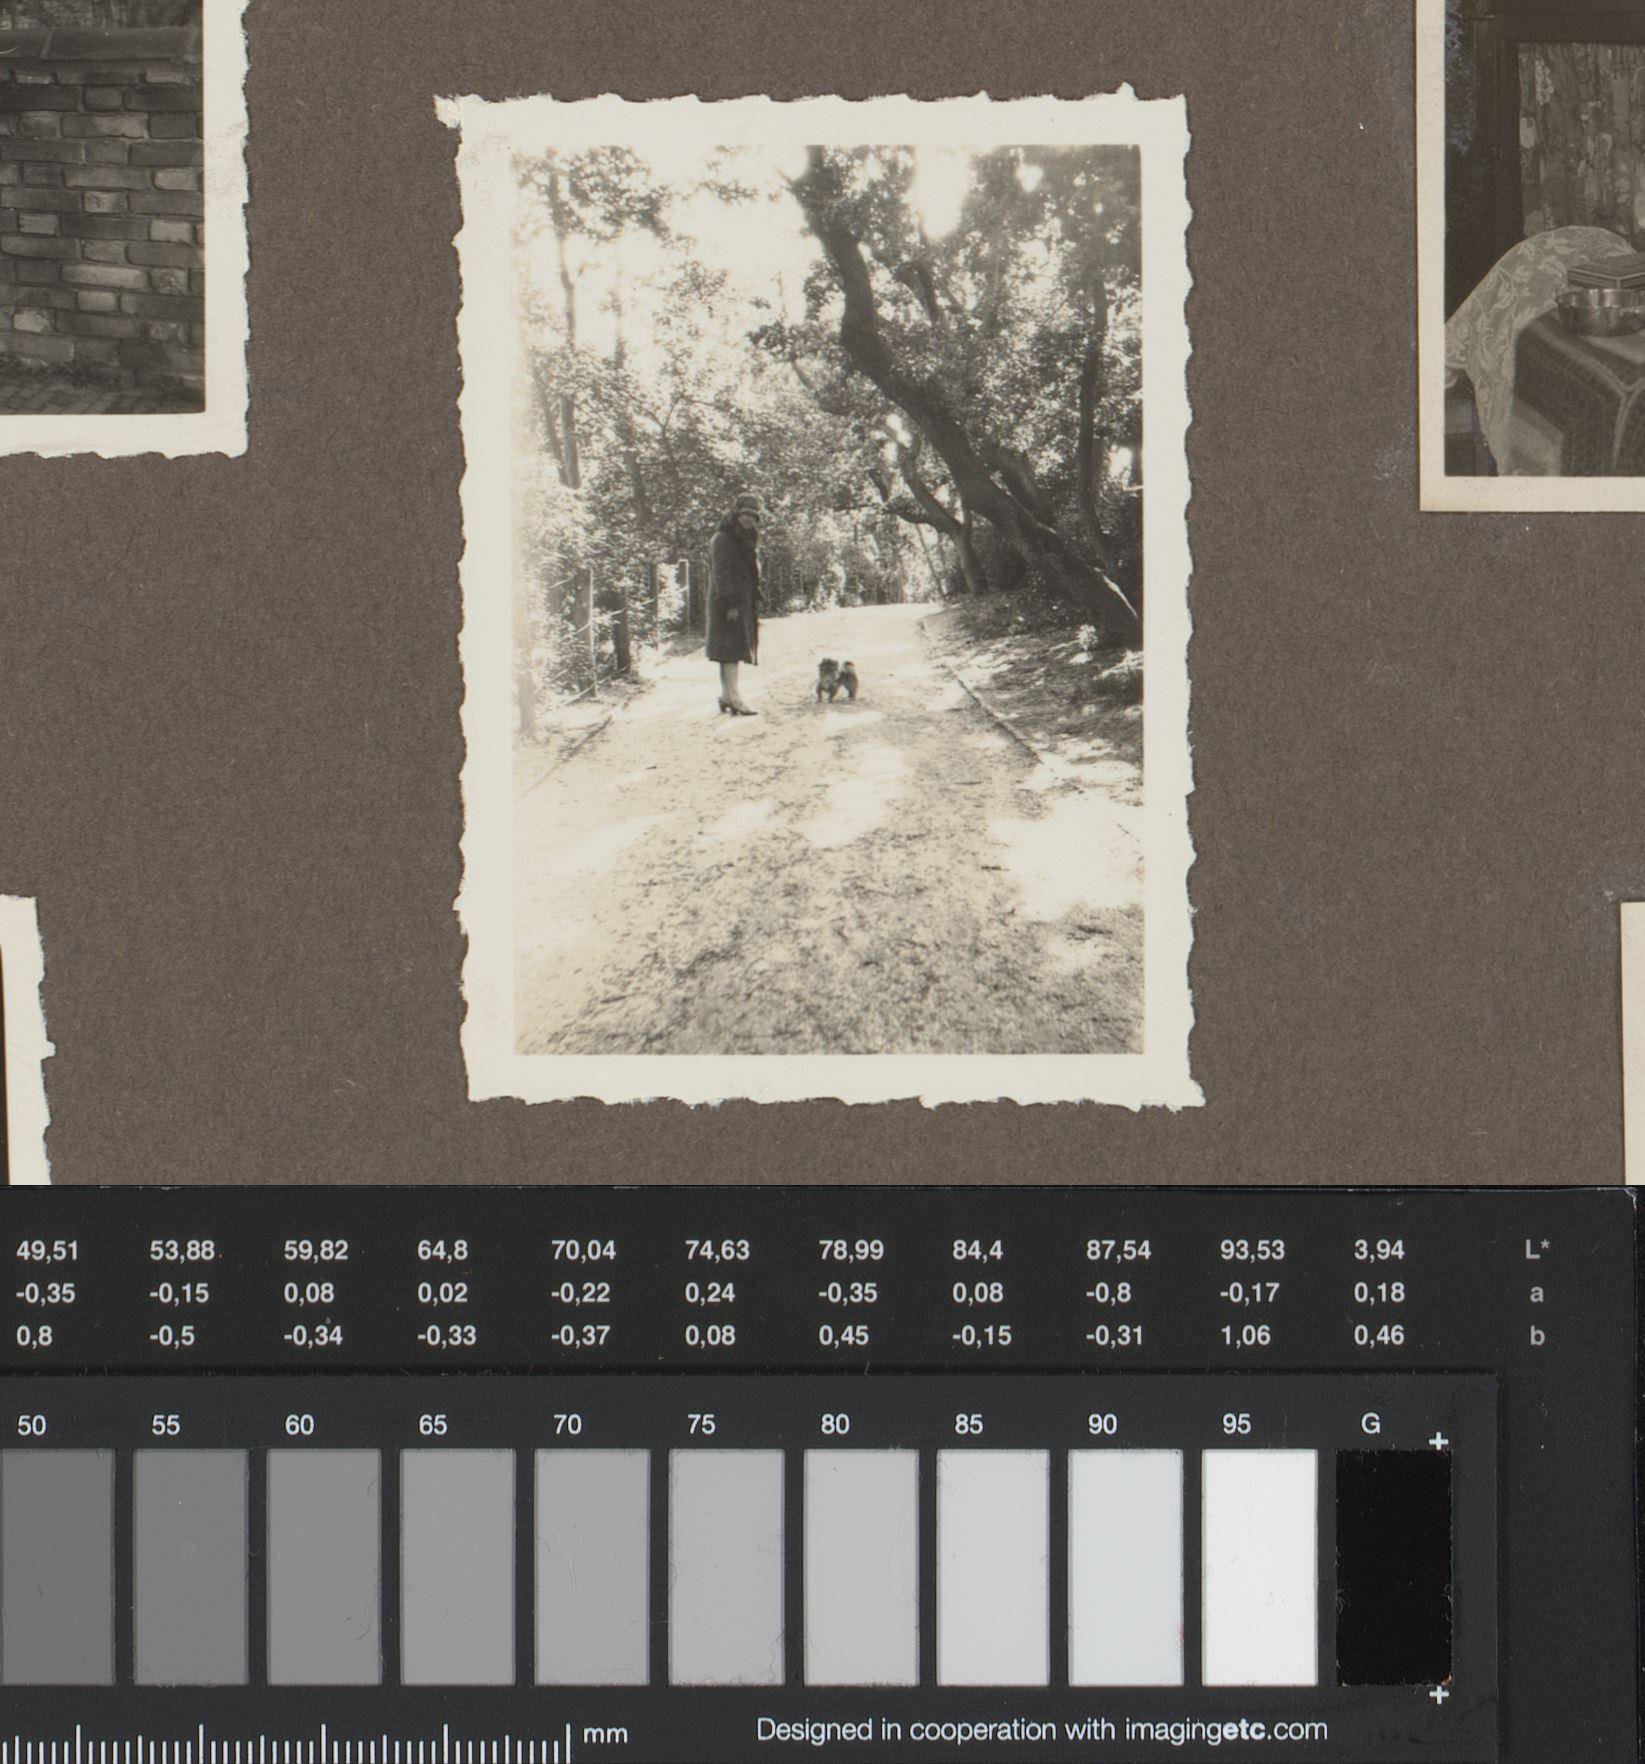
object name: album leaf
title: Henriëtte Wassink met hond op bospad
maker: Anonymous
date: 1930-1935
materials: paper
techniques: gelatin silver print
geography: netherlands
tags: batavia, the hague, henriëtte wassink, adult woman, dog, netherlands